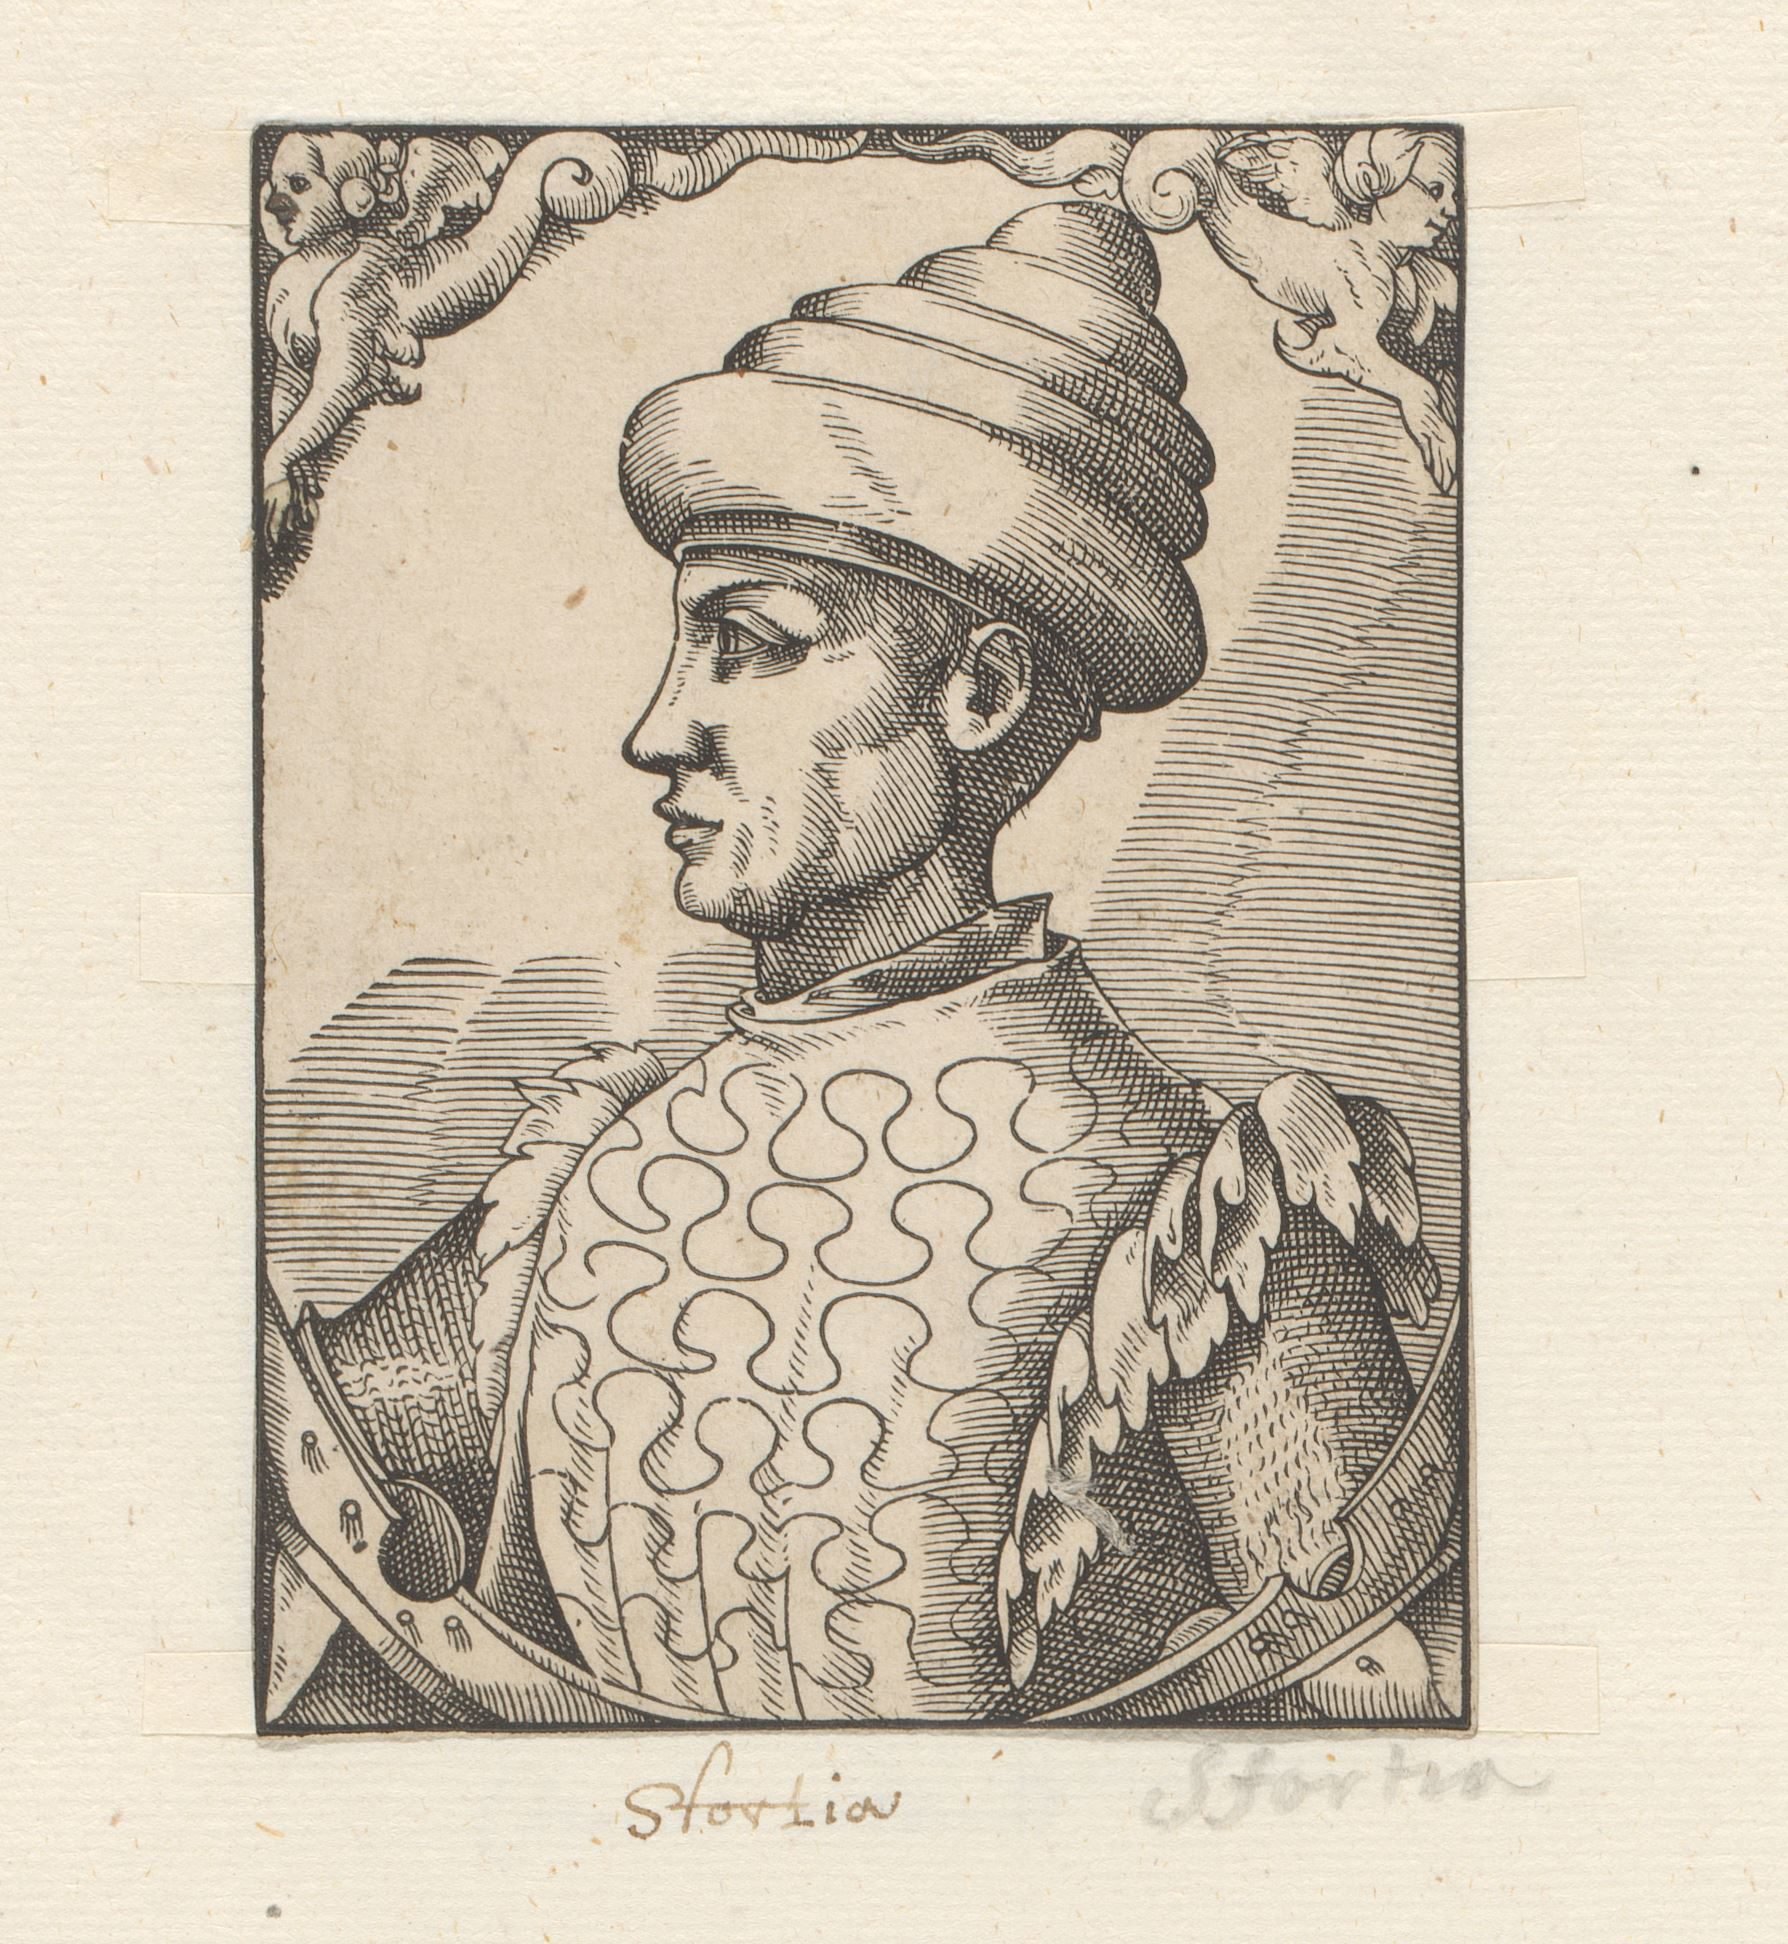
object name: album leaf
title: Portret van Muzio Attendolo Sforza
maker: Anonymous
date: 1549-1575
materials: paper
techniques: woodcut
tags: commander-in-chief, general, marshal, historical persons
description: Prent gebruikt in: Giovio, Paolo. Elogia Virorum bellica virtute illustrium (...). Bazel: Peter Perna, 1575.